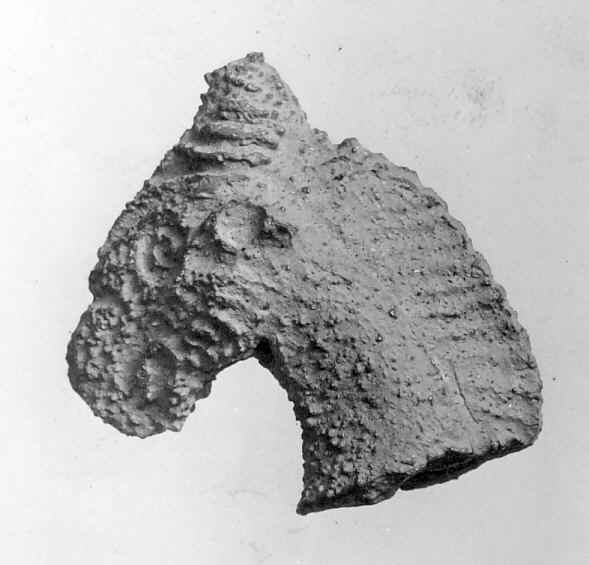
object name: ornament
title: Head of Horse or Camel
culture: central asian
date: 1101-1133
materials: terracotta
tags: animals